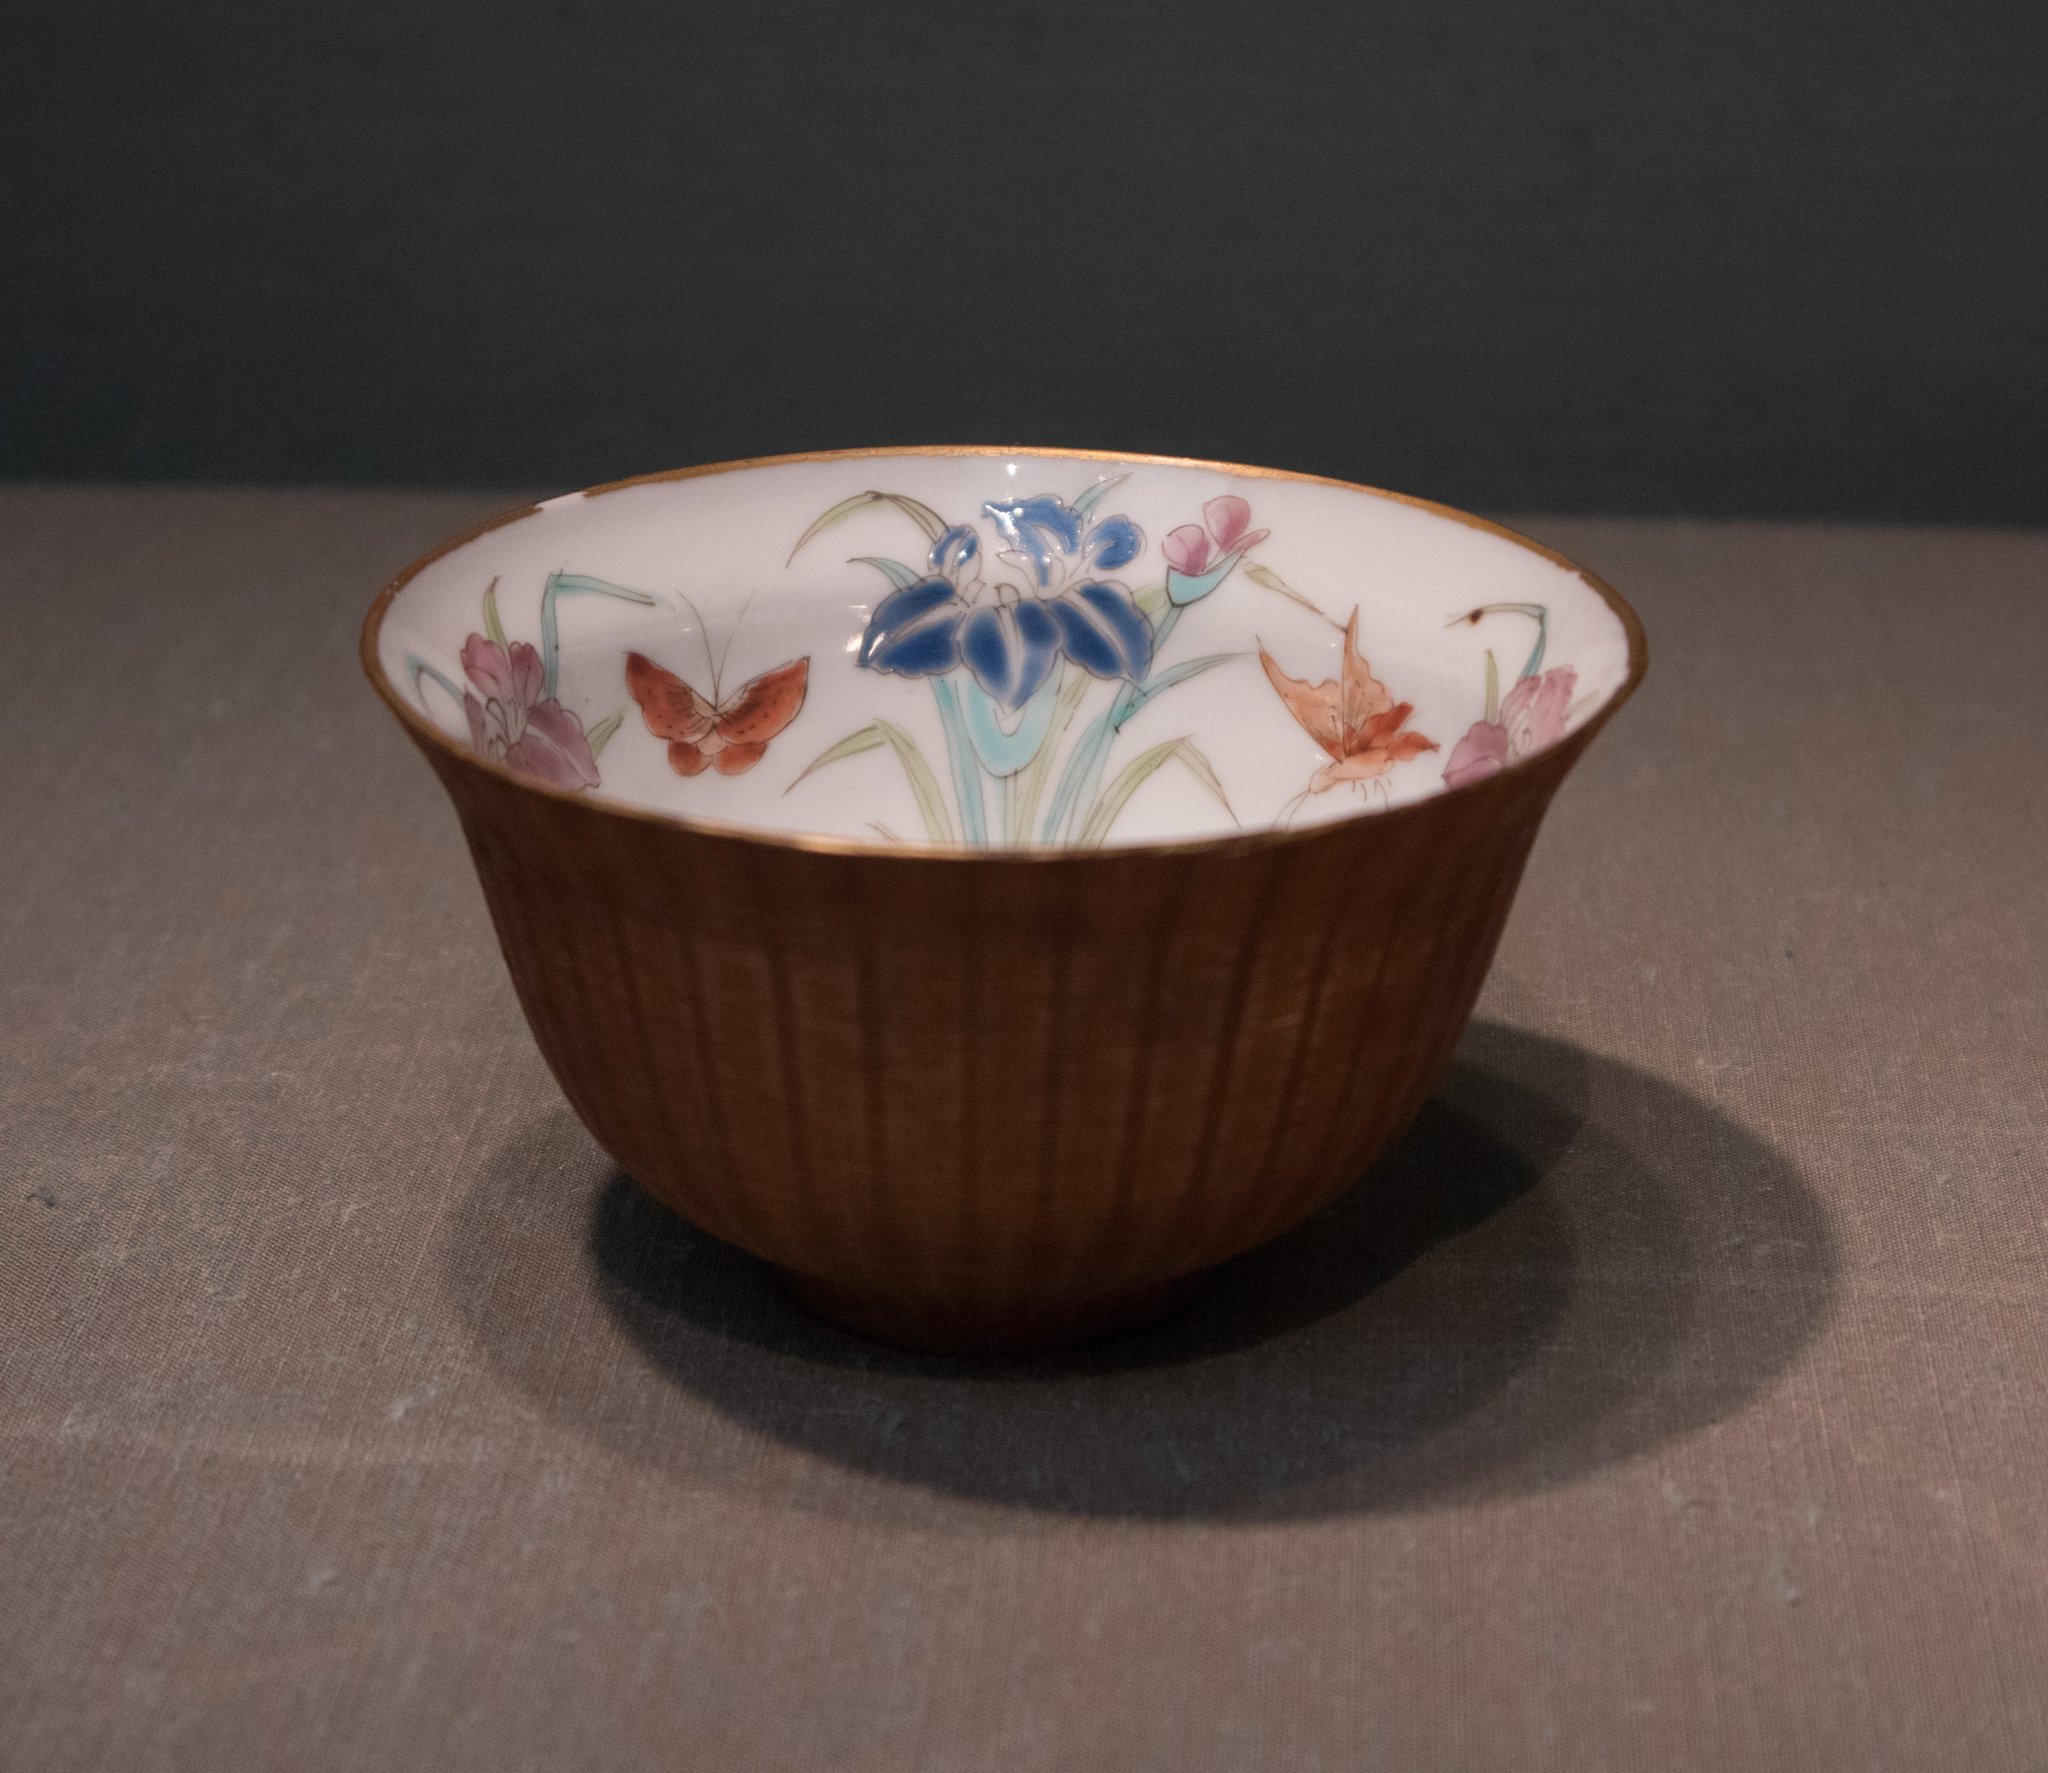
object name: cup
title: Cup with Butterflies-and-Iris Design and Basketry Exterior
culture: japanese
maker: zōshuntei sanpo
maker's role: artist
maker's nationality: japanese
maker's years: 1841-1878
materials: enamel, porcelain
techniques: overglaze, polychrome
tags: flowers